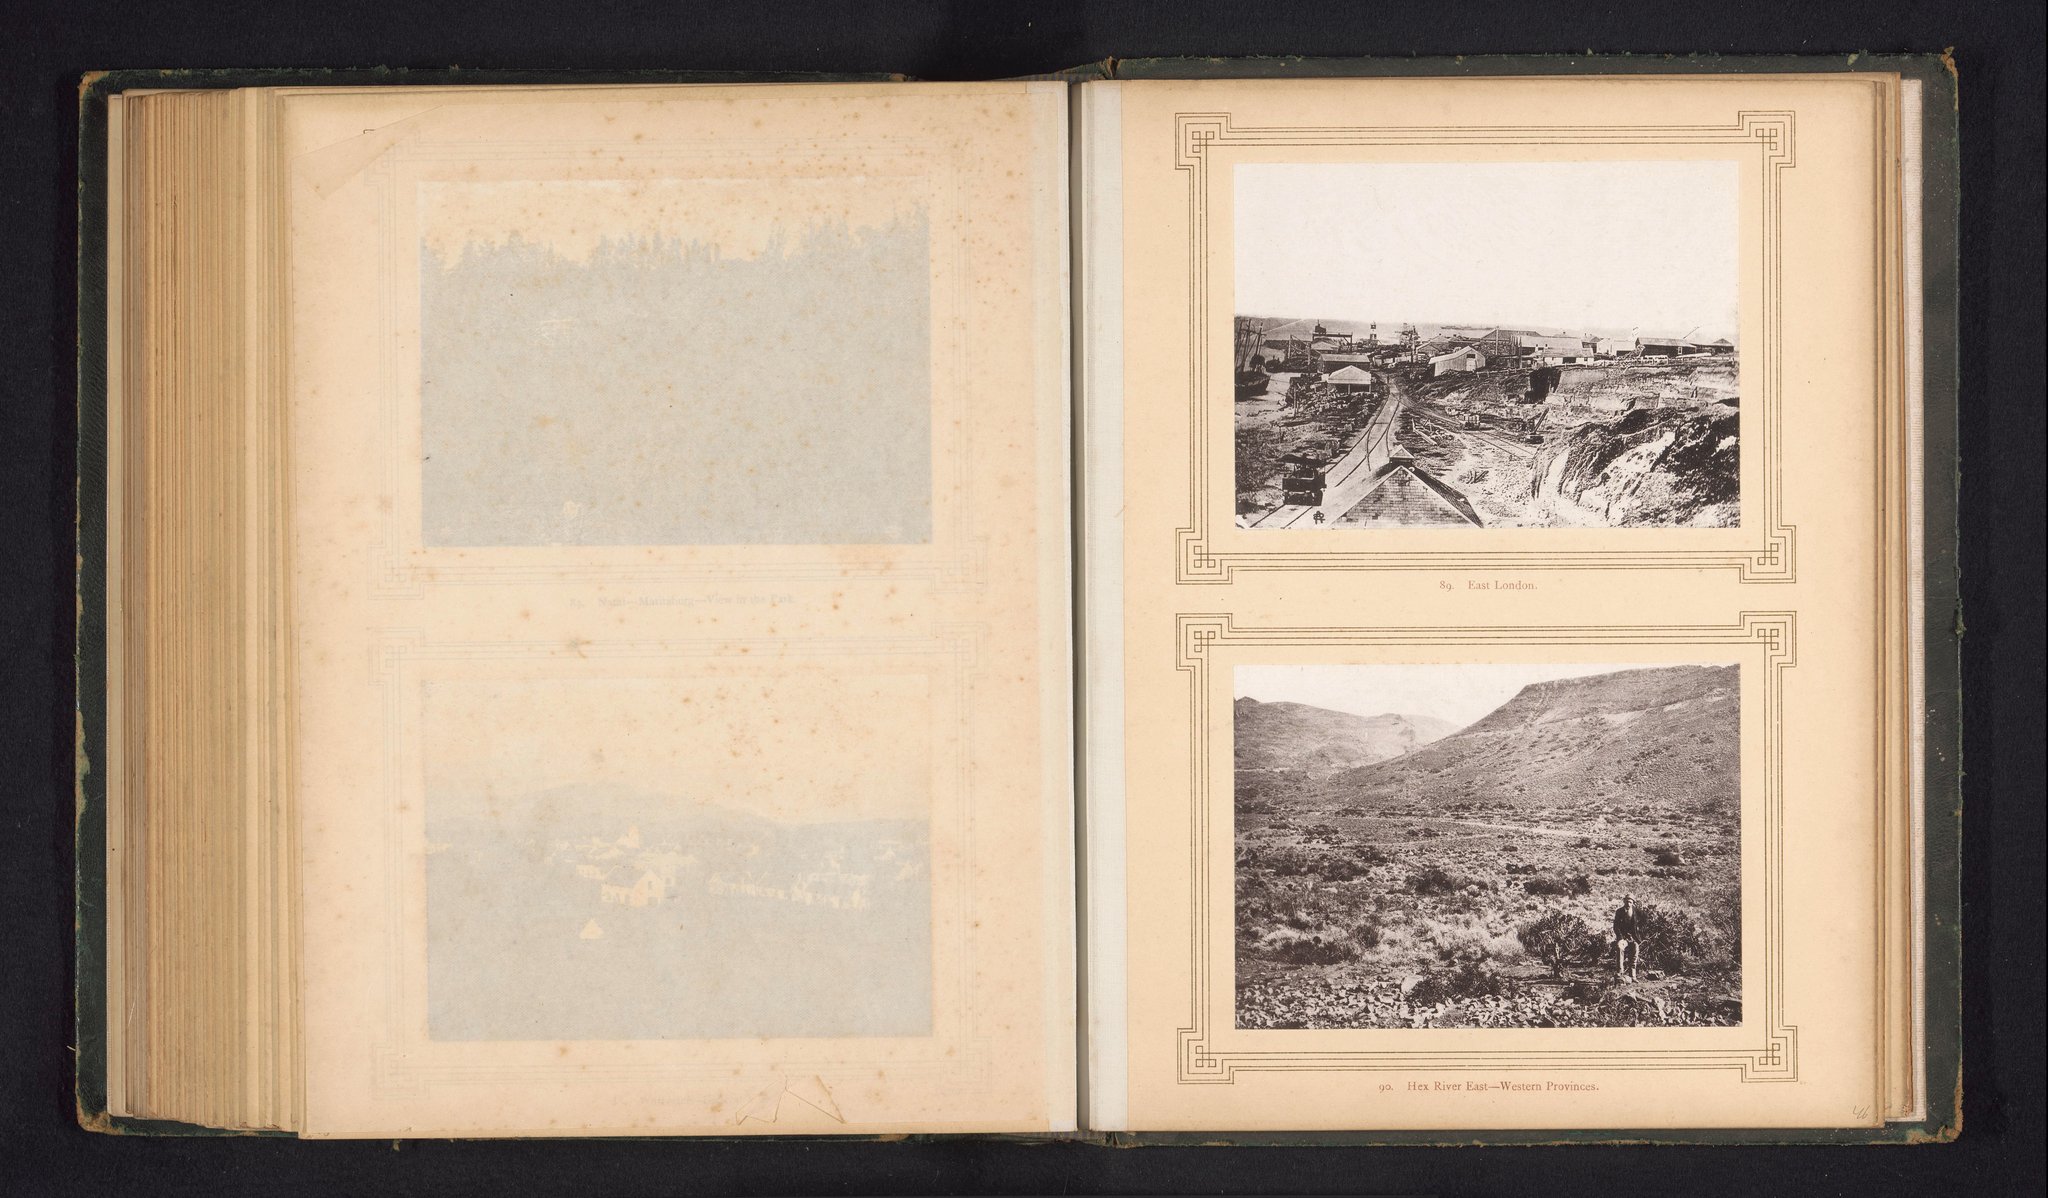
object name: photomechanical print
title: East London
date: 1870-1880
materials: paper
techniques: photograph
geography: south africa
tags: dale, valley, industries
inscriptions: number: ‘89. 90.’, inscription: ‘SA’